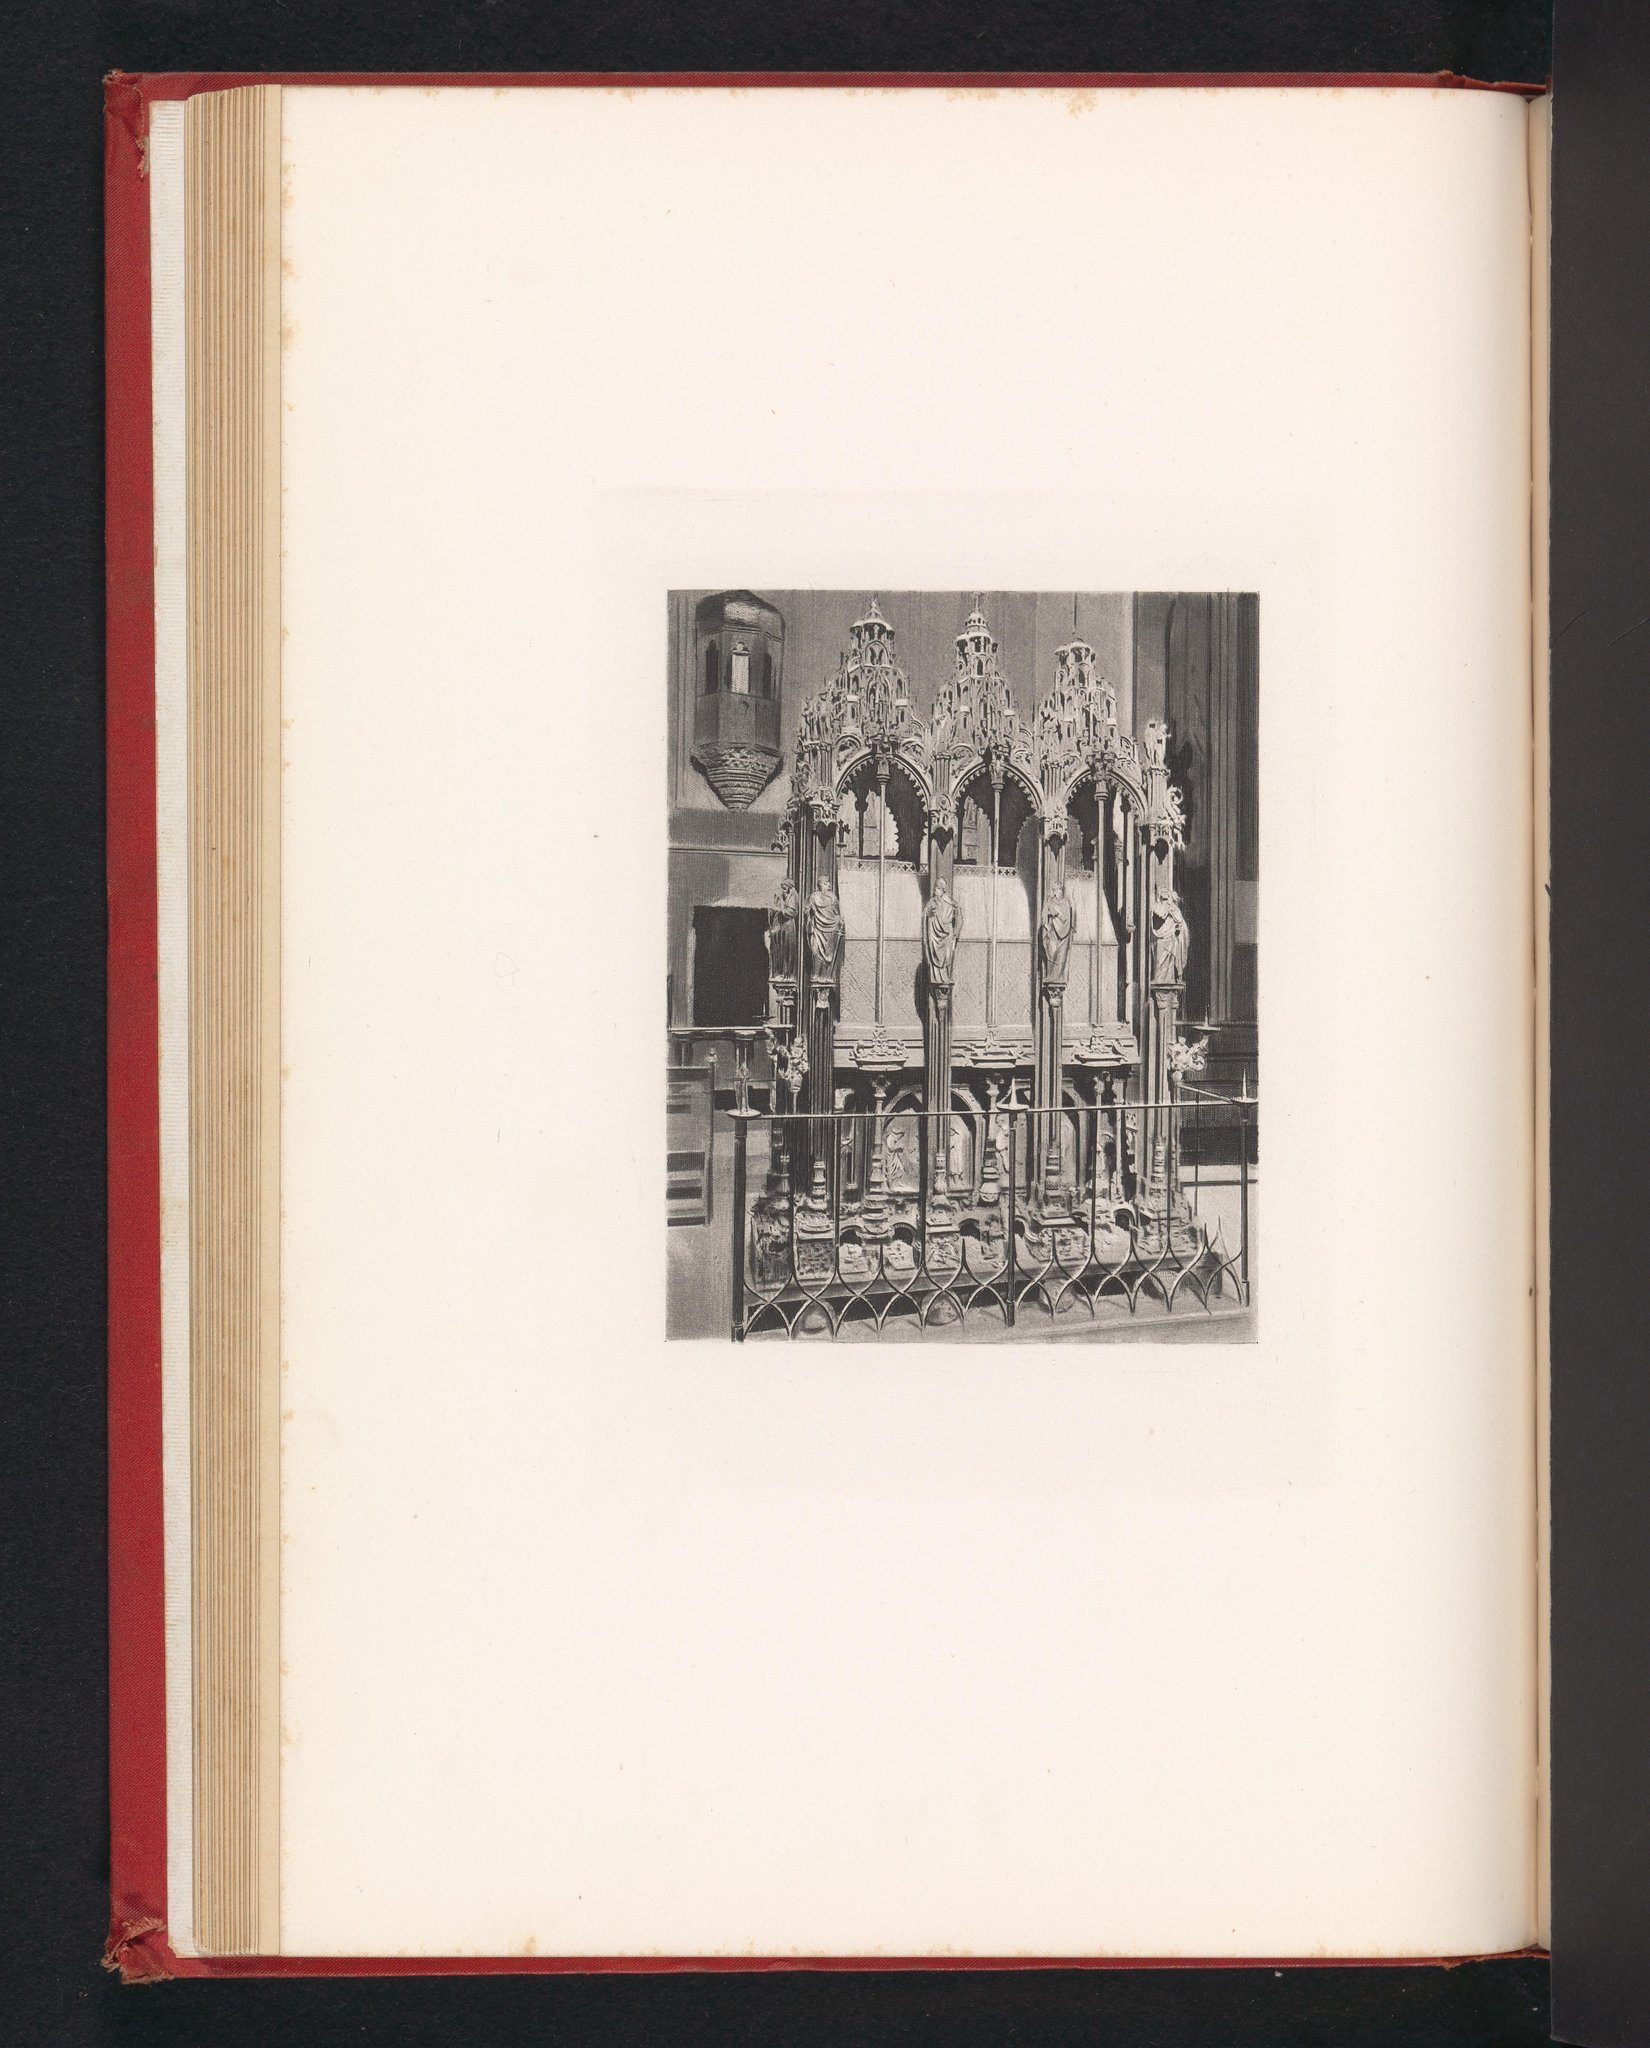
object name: page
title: Shrine of St. Sebald, by Peter Vischer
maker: Anonymous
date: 1878-1888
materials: paper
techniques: photoaquatint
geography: sint-sebalduskerk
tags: grave, tomb